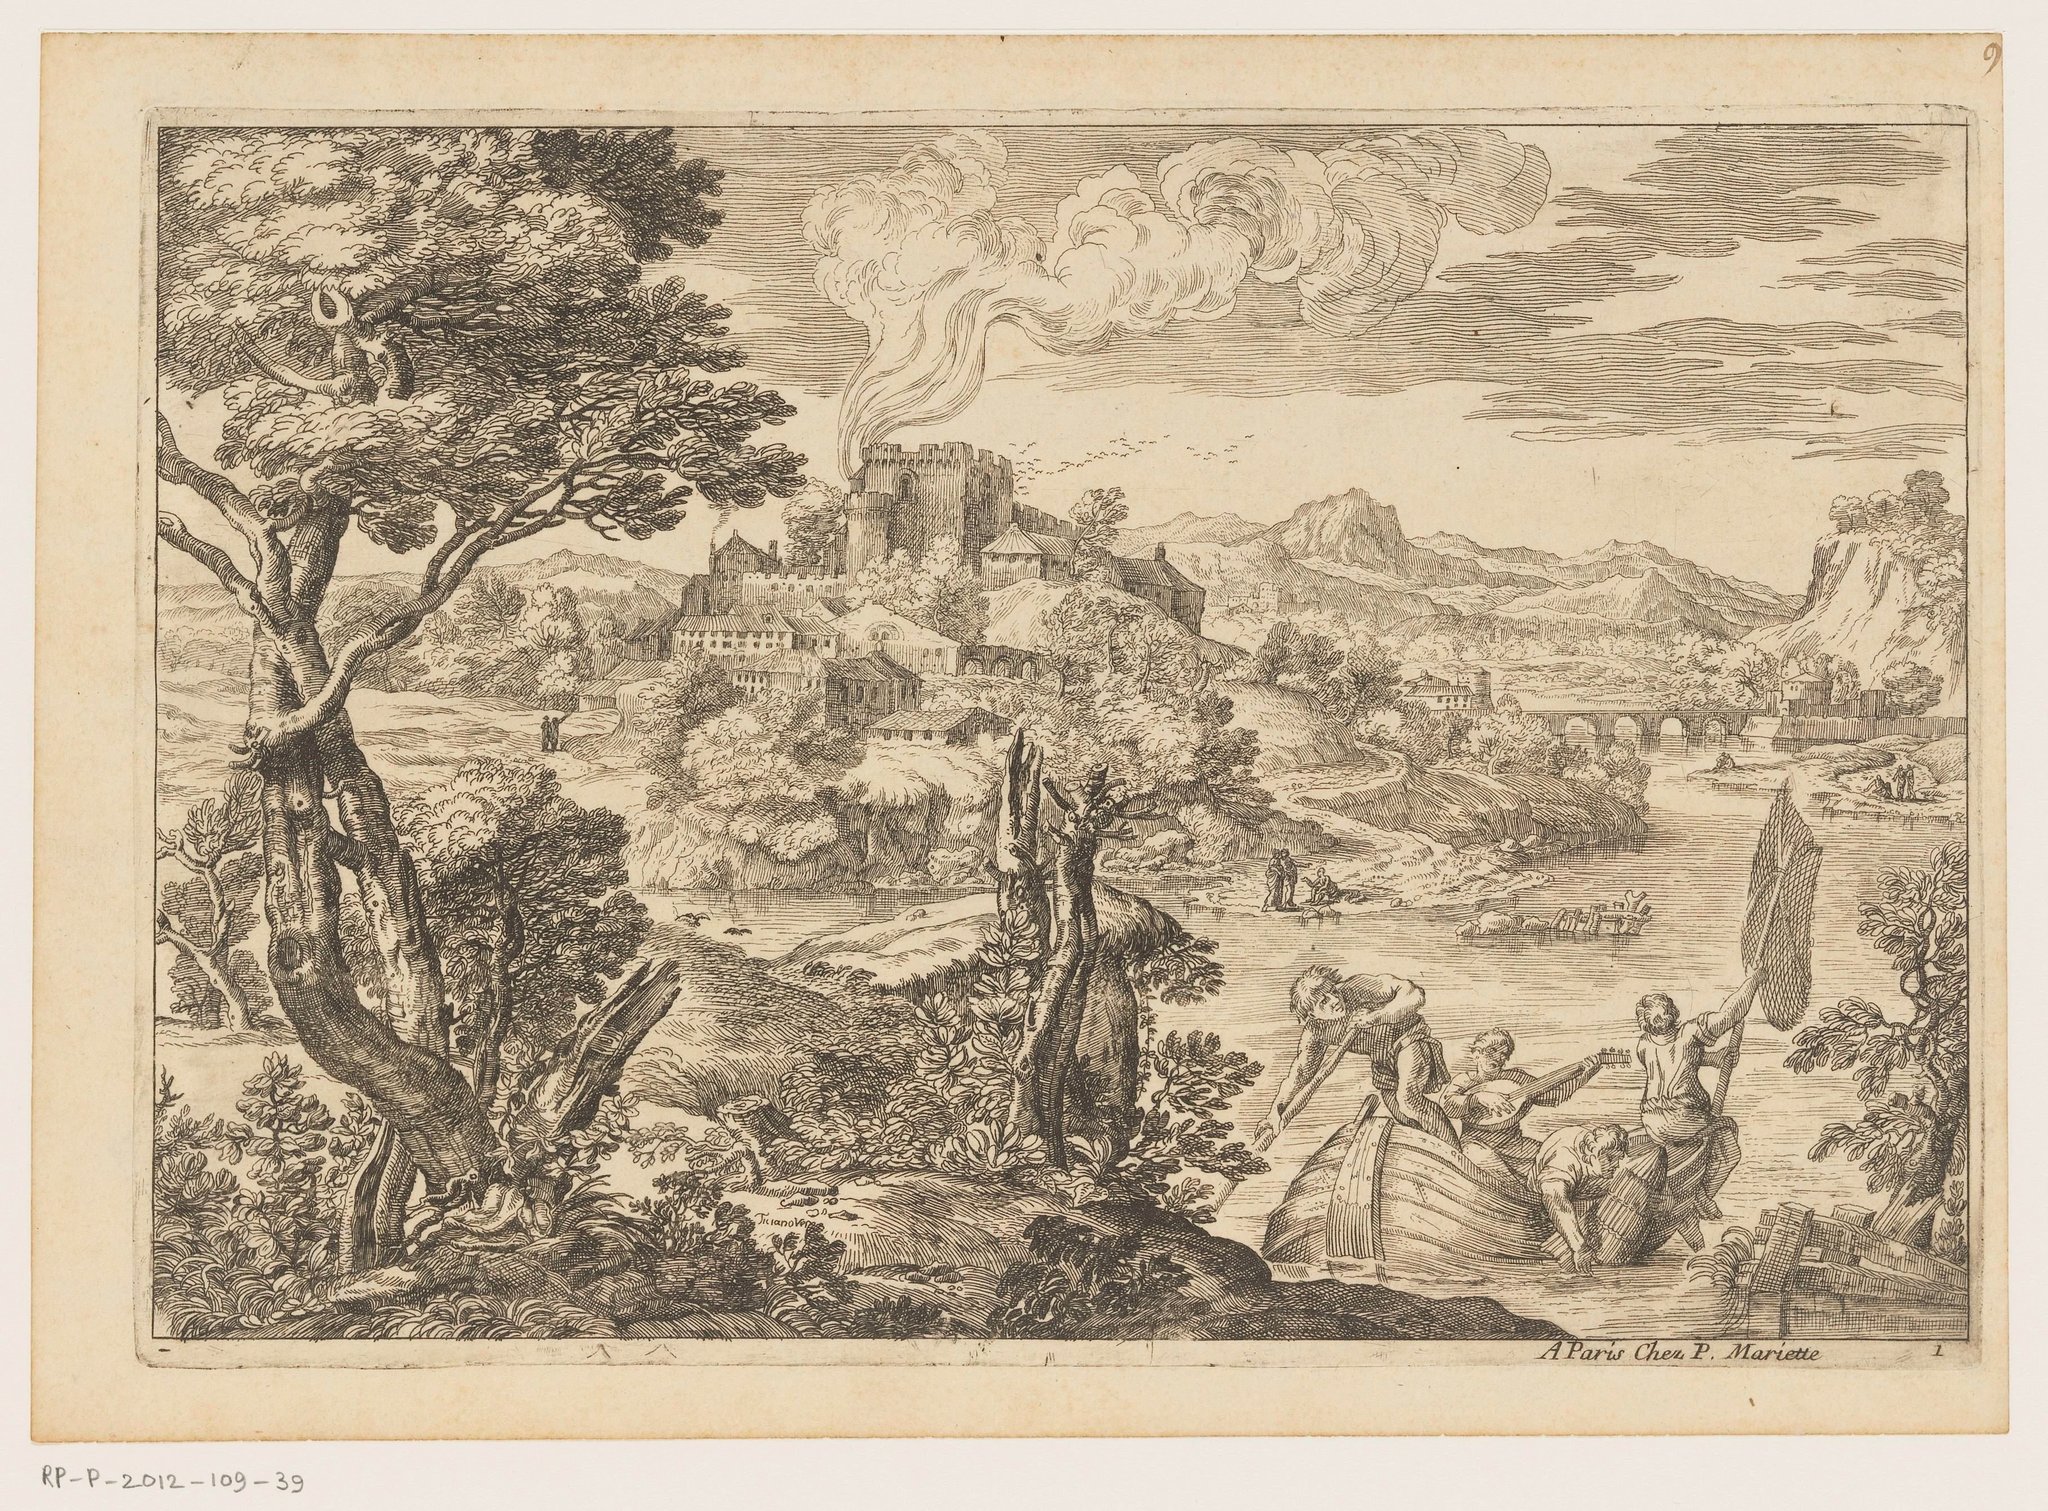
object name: print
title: Landschappen naar Titiaan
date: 1663-1726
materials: paper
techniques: etching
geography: paris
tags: fresh-water fishery, musician - cc - out of doors, landscapes with waters, waterscapes, seascapes (in the temperate zone)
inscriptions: collector's mark: Lugt 3473, collector's mark: Lugt 2228, collector's mark: Lugt 3474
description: Maakt deel uit van vierentwintigdelige serie met landschappen naar Titiaan en Campagnola.